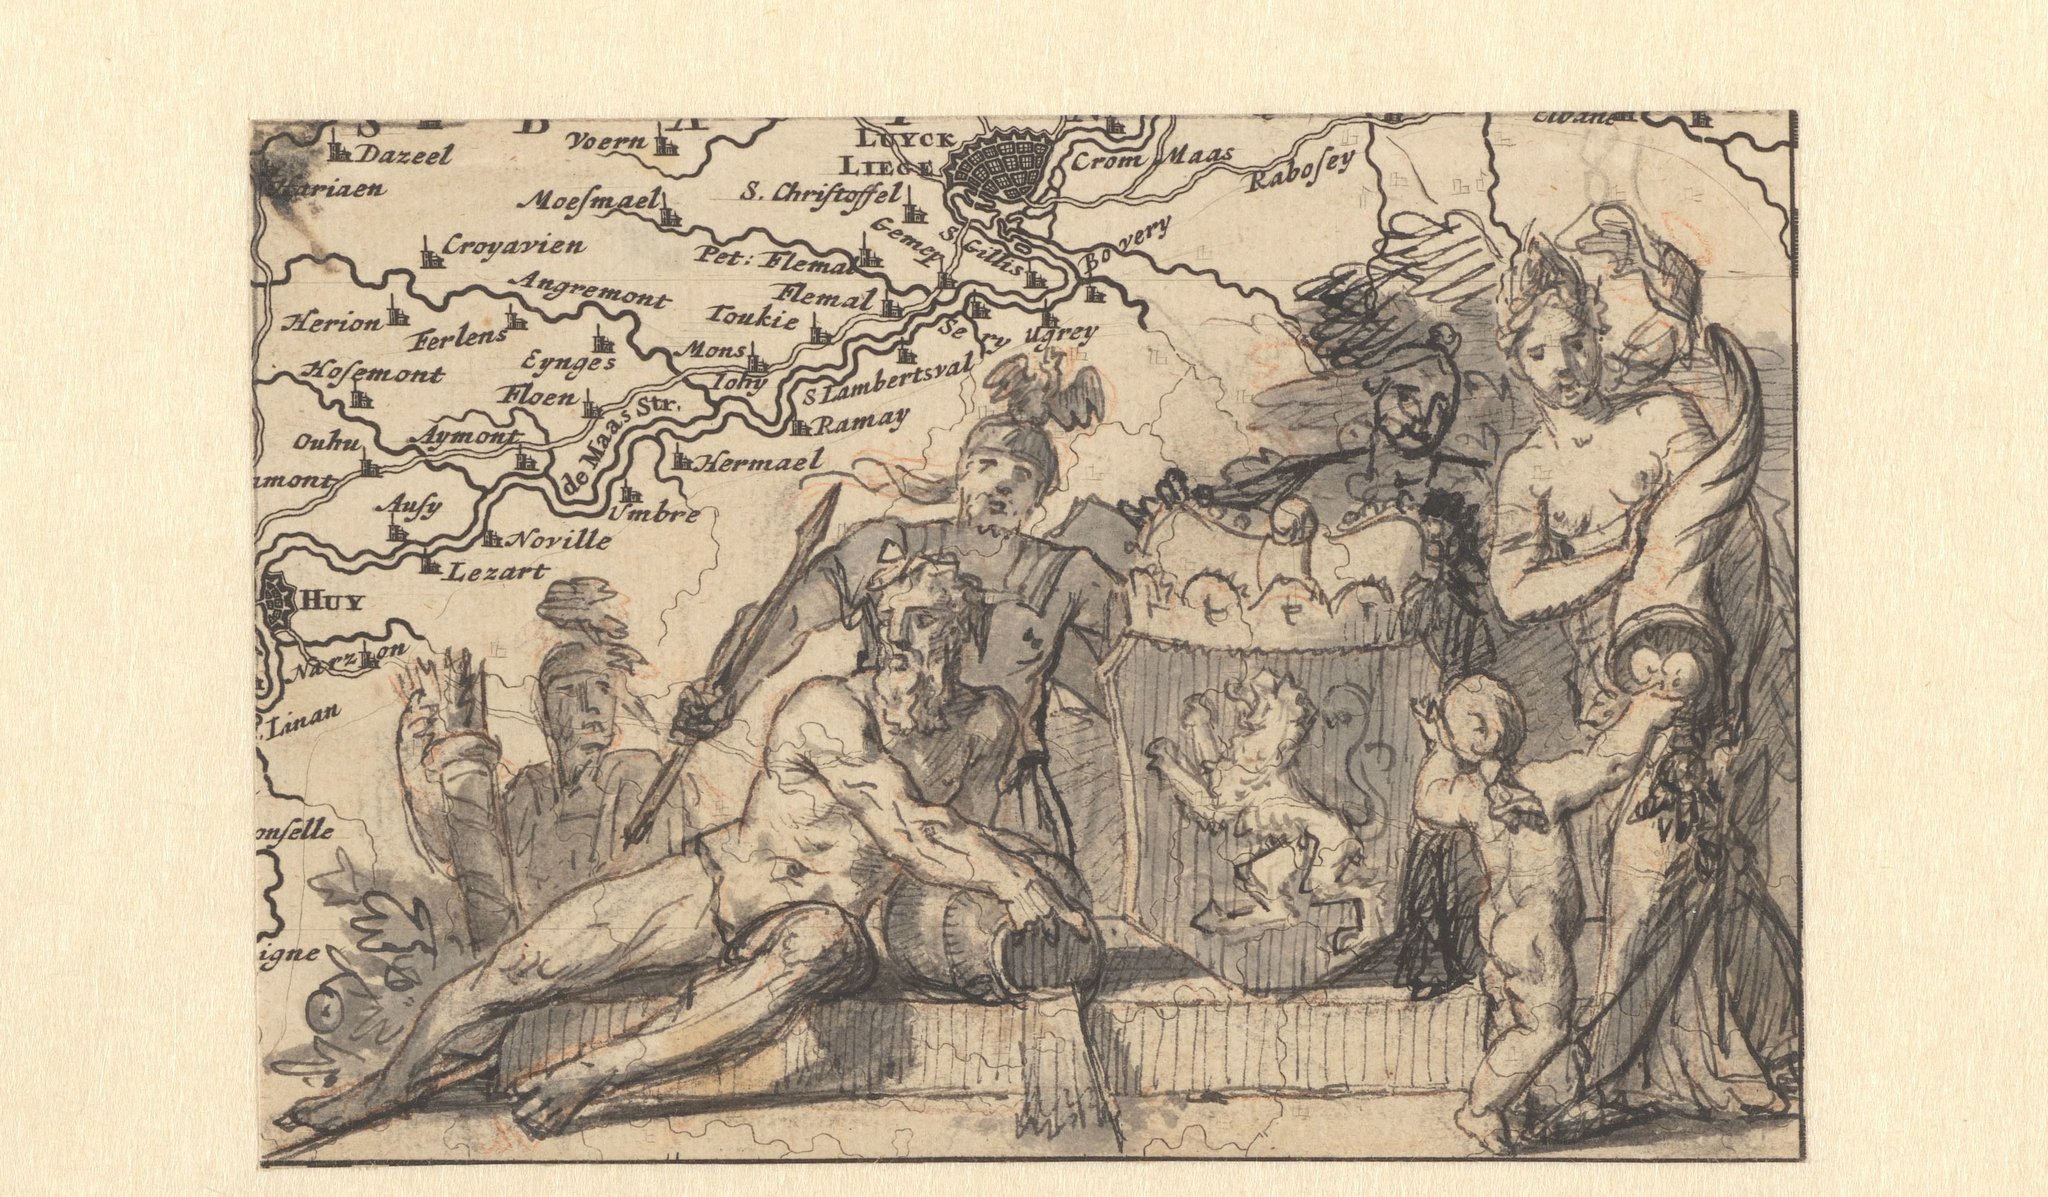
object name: drawing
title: Ontwerp voor een vignet met het wapen van Brabant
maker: gerard de lairesse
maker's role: draughtsman, painter, print maker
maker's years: 1641-1711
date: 1668-1670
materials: chalk, paper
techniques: brush, engraving, pen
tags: maps of separate countries or regions, river personified, 'fiumi' (ripa), plenitude (+ abstract concept represented by female figure), coat of arms (as symbol of the state, etc.) (+ province; provincial)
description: Links een stroomgod. Rechts een vrouw met een hoorn des overvloeds. Proefdruk van een landkaart met de ontwerptekening voor een vignet in de gravure getekend. Ontwerp voor een prent.